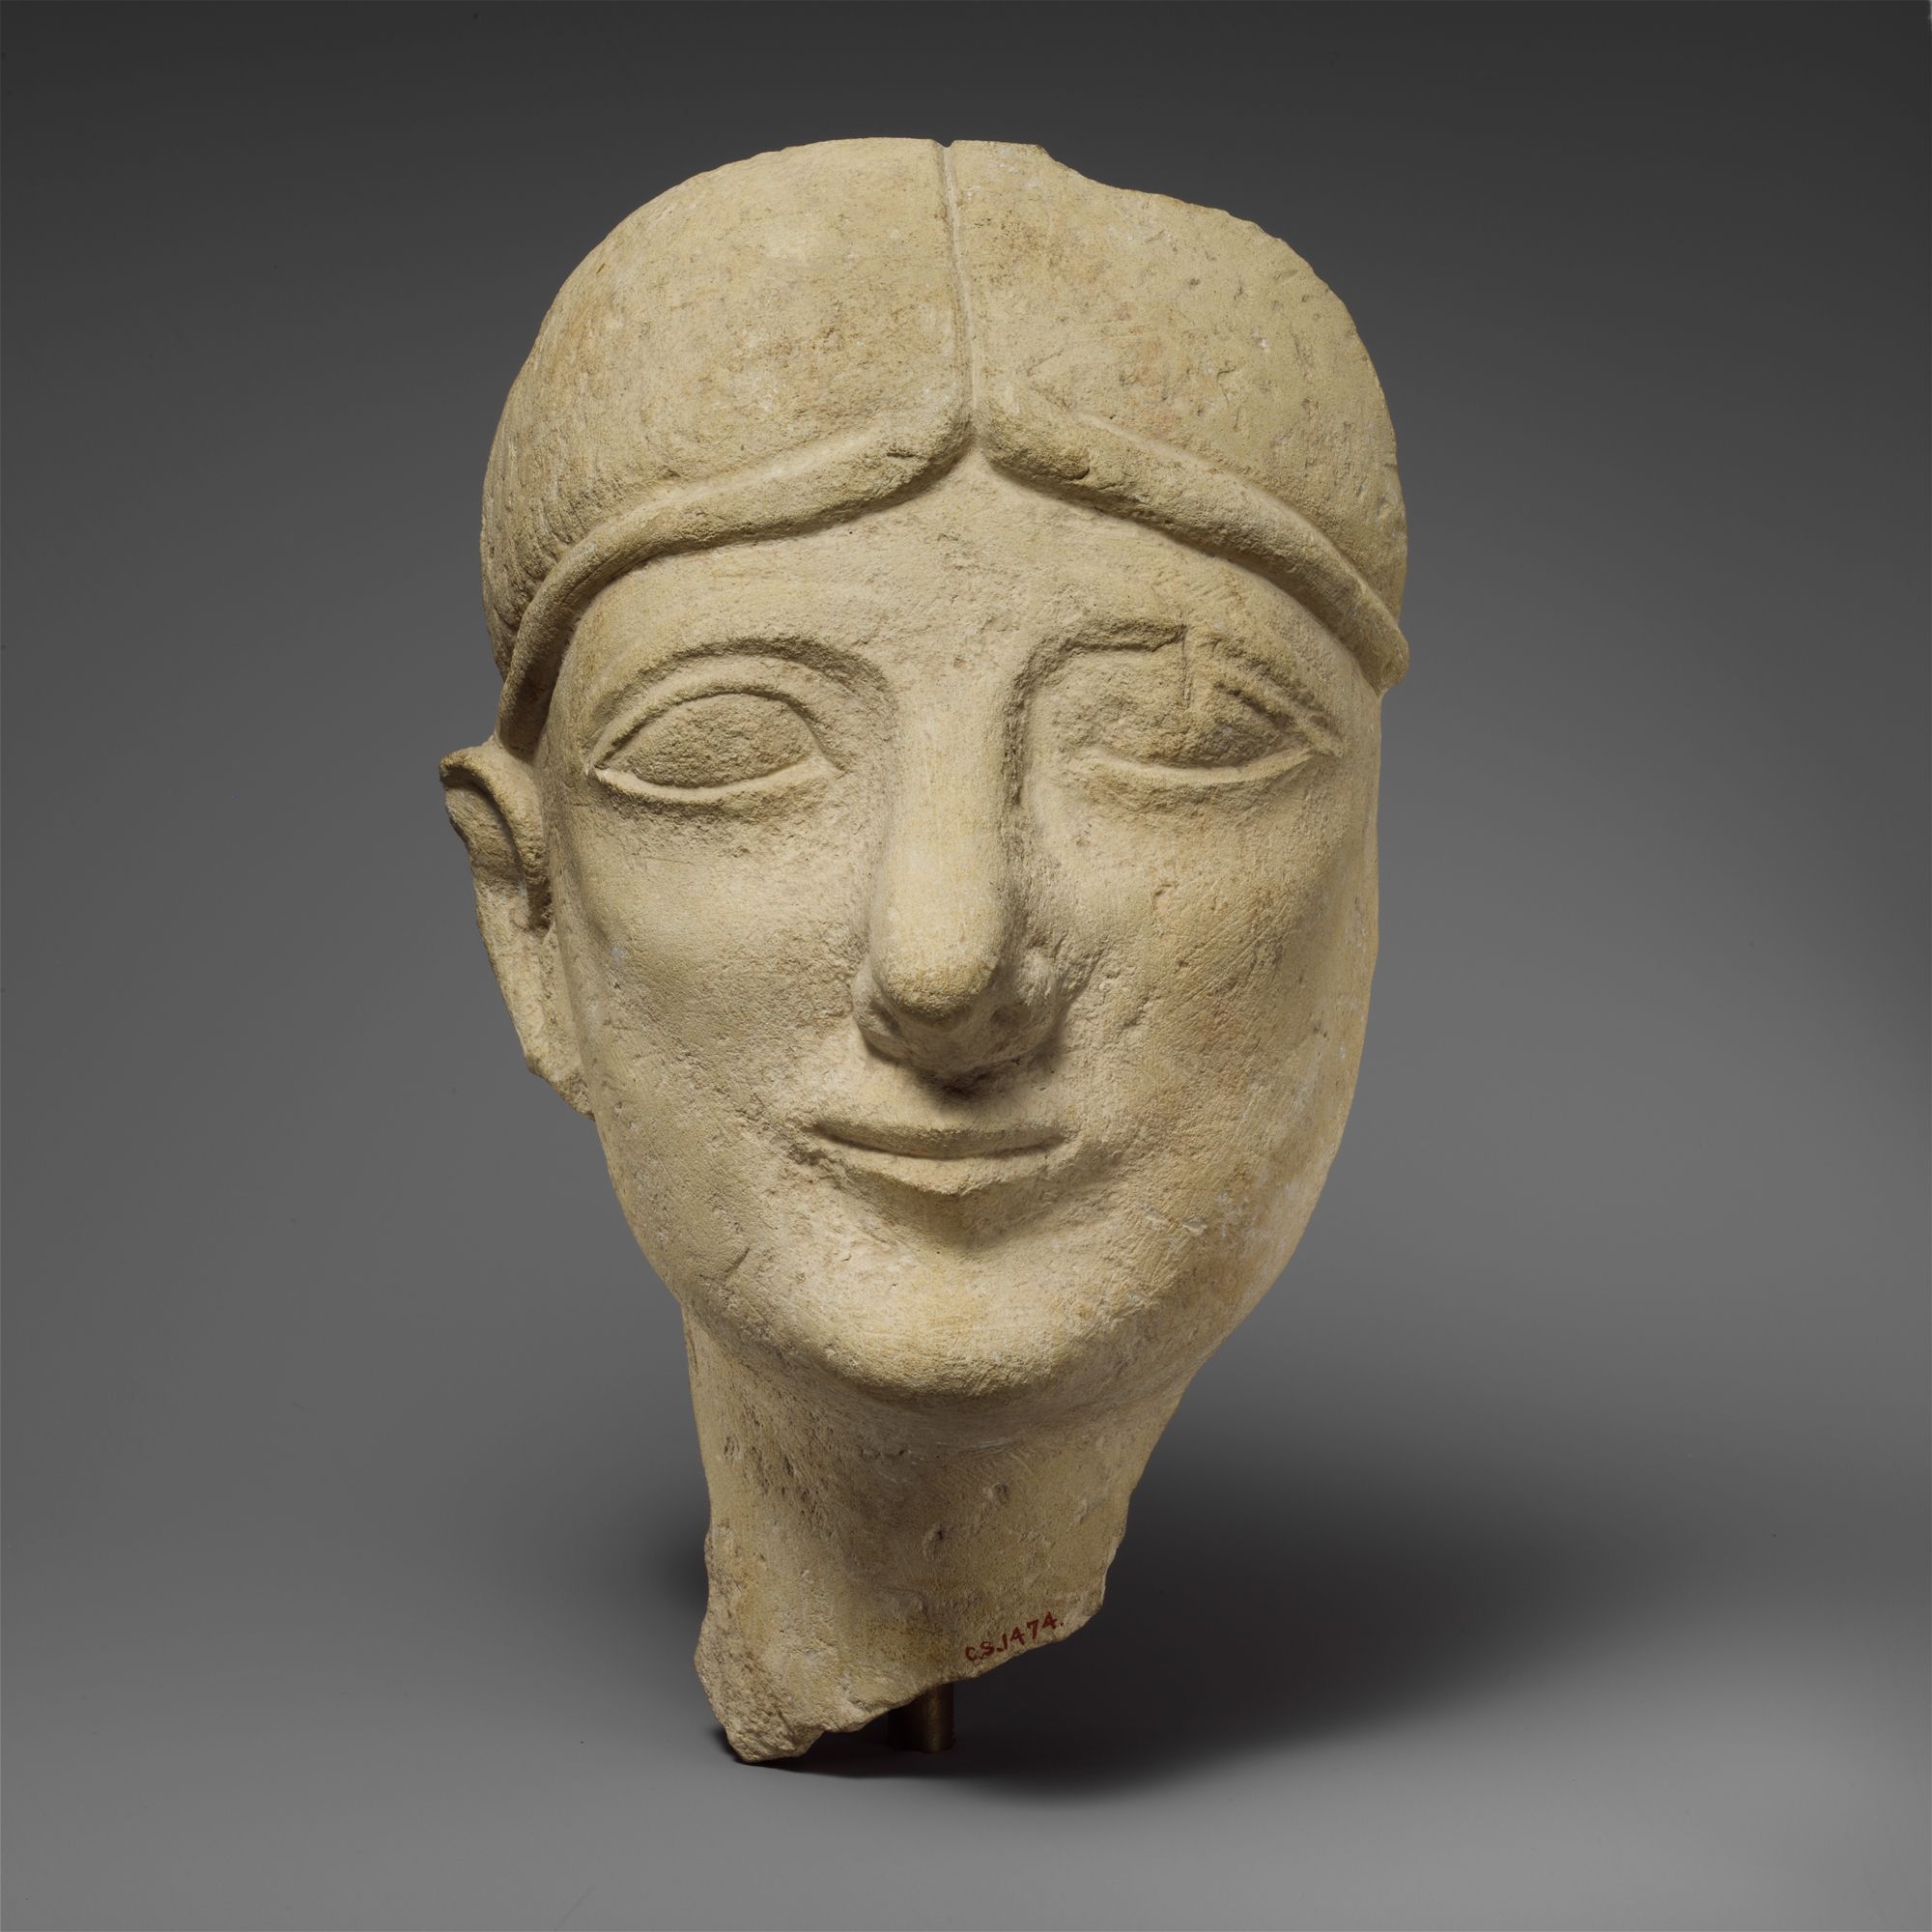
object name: head of a votary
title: Limestone head of a beardless male with a fillet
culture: cypriot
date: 600-551 BCE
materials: limestone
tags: heads,men